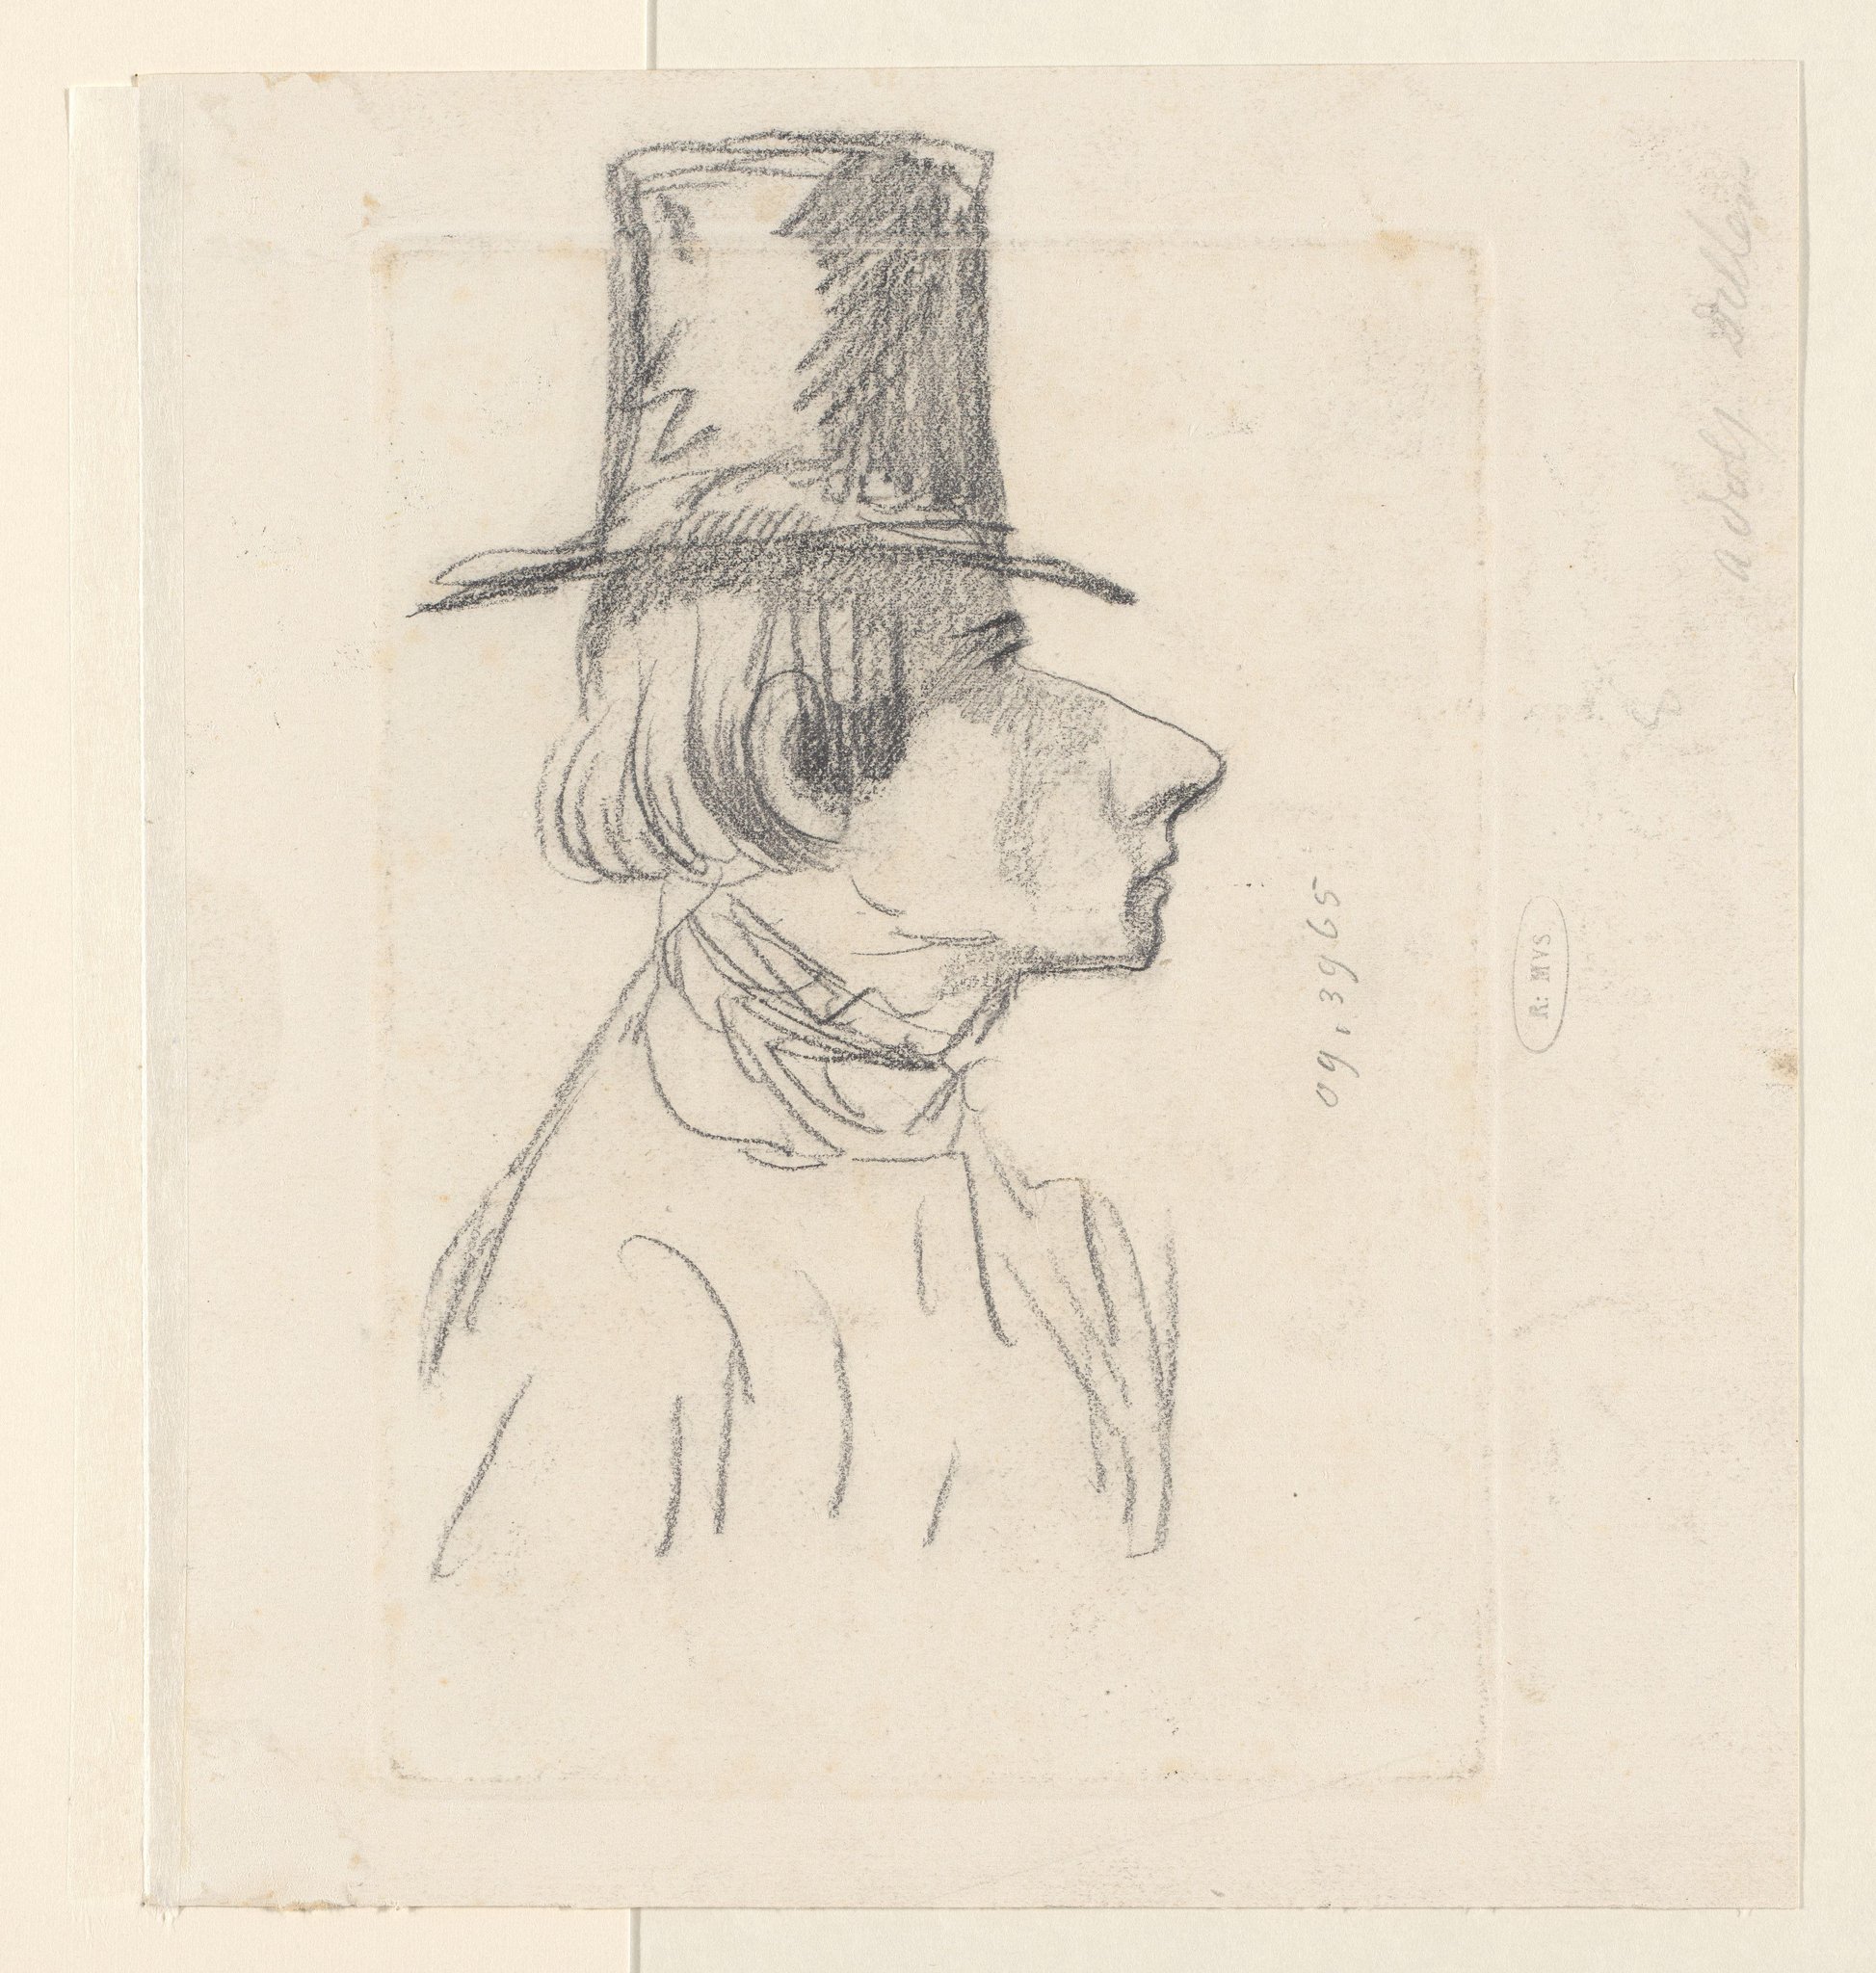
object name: drawing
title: Man met hoed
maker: adolphe alexandre dillens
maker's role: draughtsman, painter, print maker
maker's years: 1821-1877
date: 1831-1877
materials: paper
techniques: etching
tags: head-gear, adult man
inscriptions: collector's mark: Lugt 2228